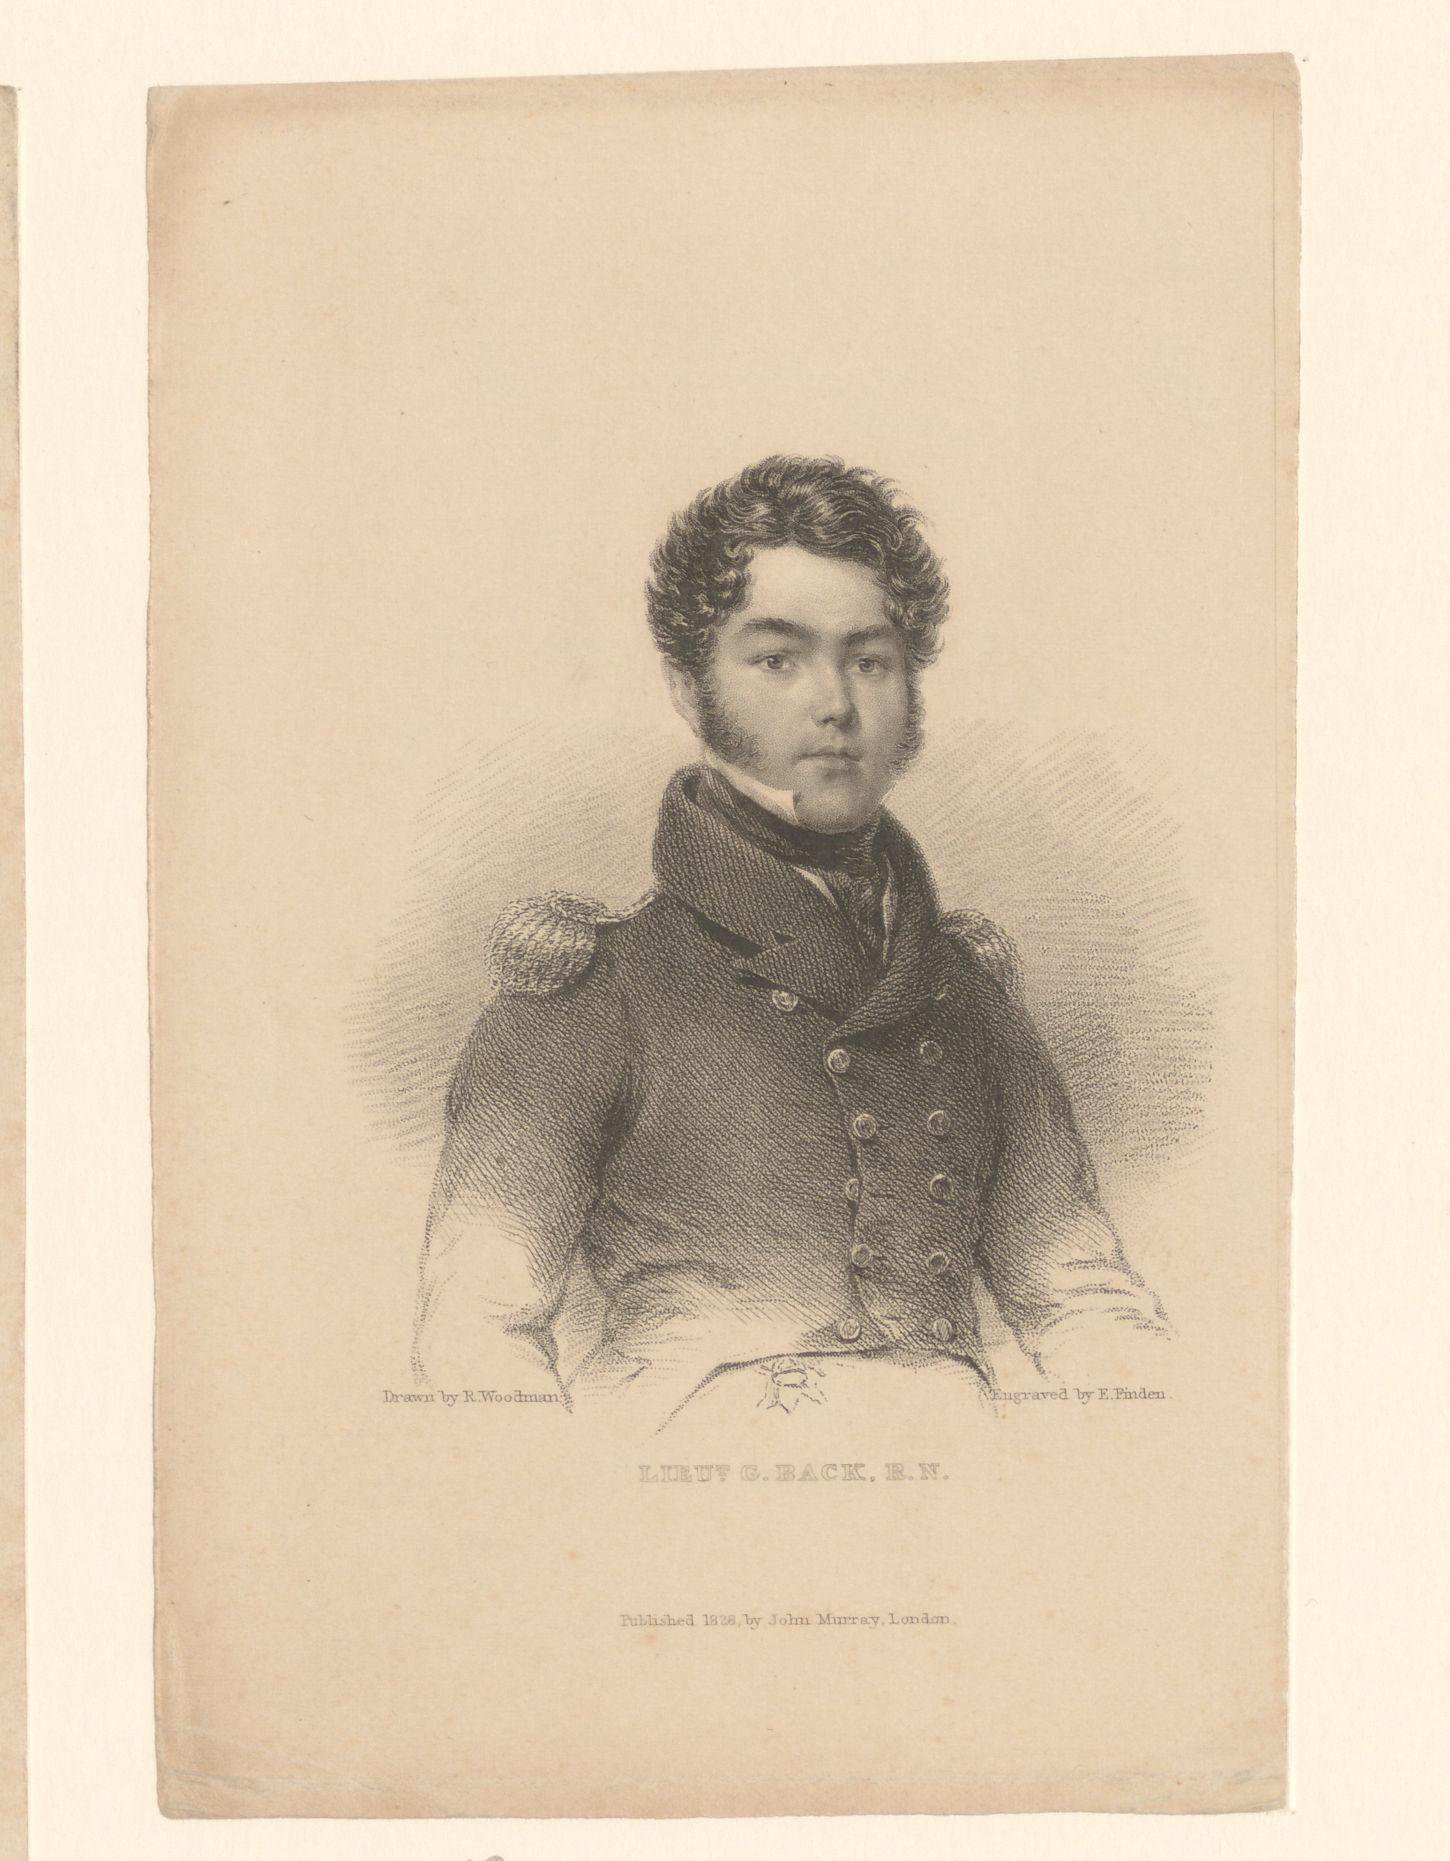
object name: print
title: Portret van George Back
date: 1828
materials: paper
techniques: etching, roulette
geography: london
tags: historical persons, commander-in-chief, admiral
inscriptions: collector's mark: Lugt 2228